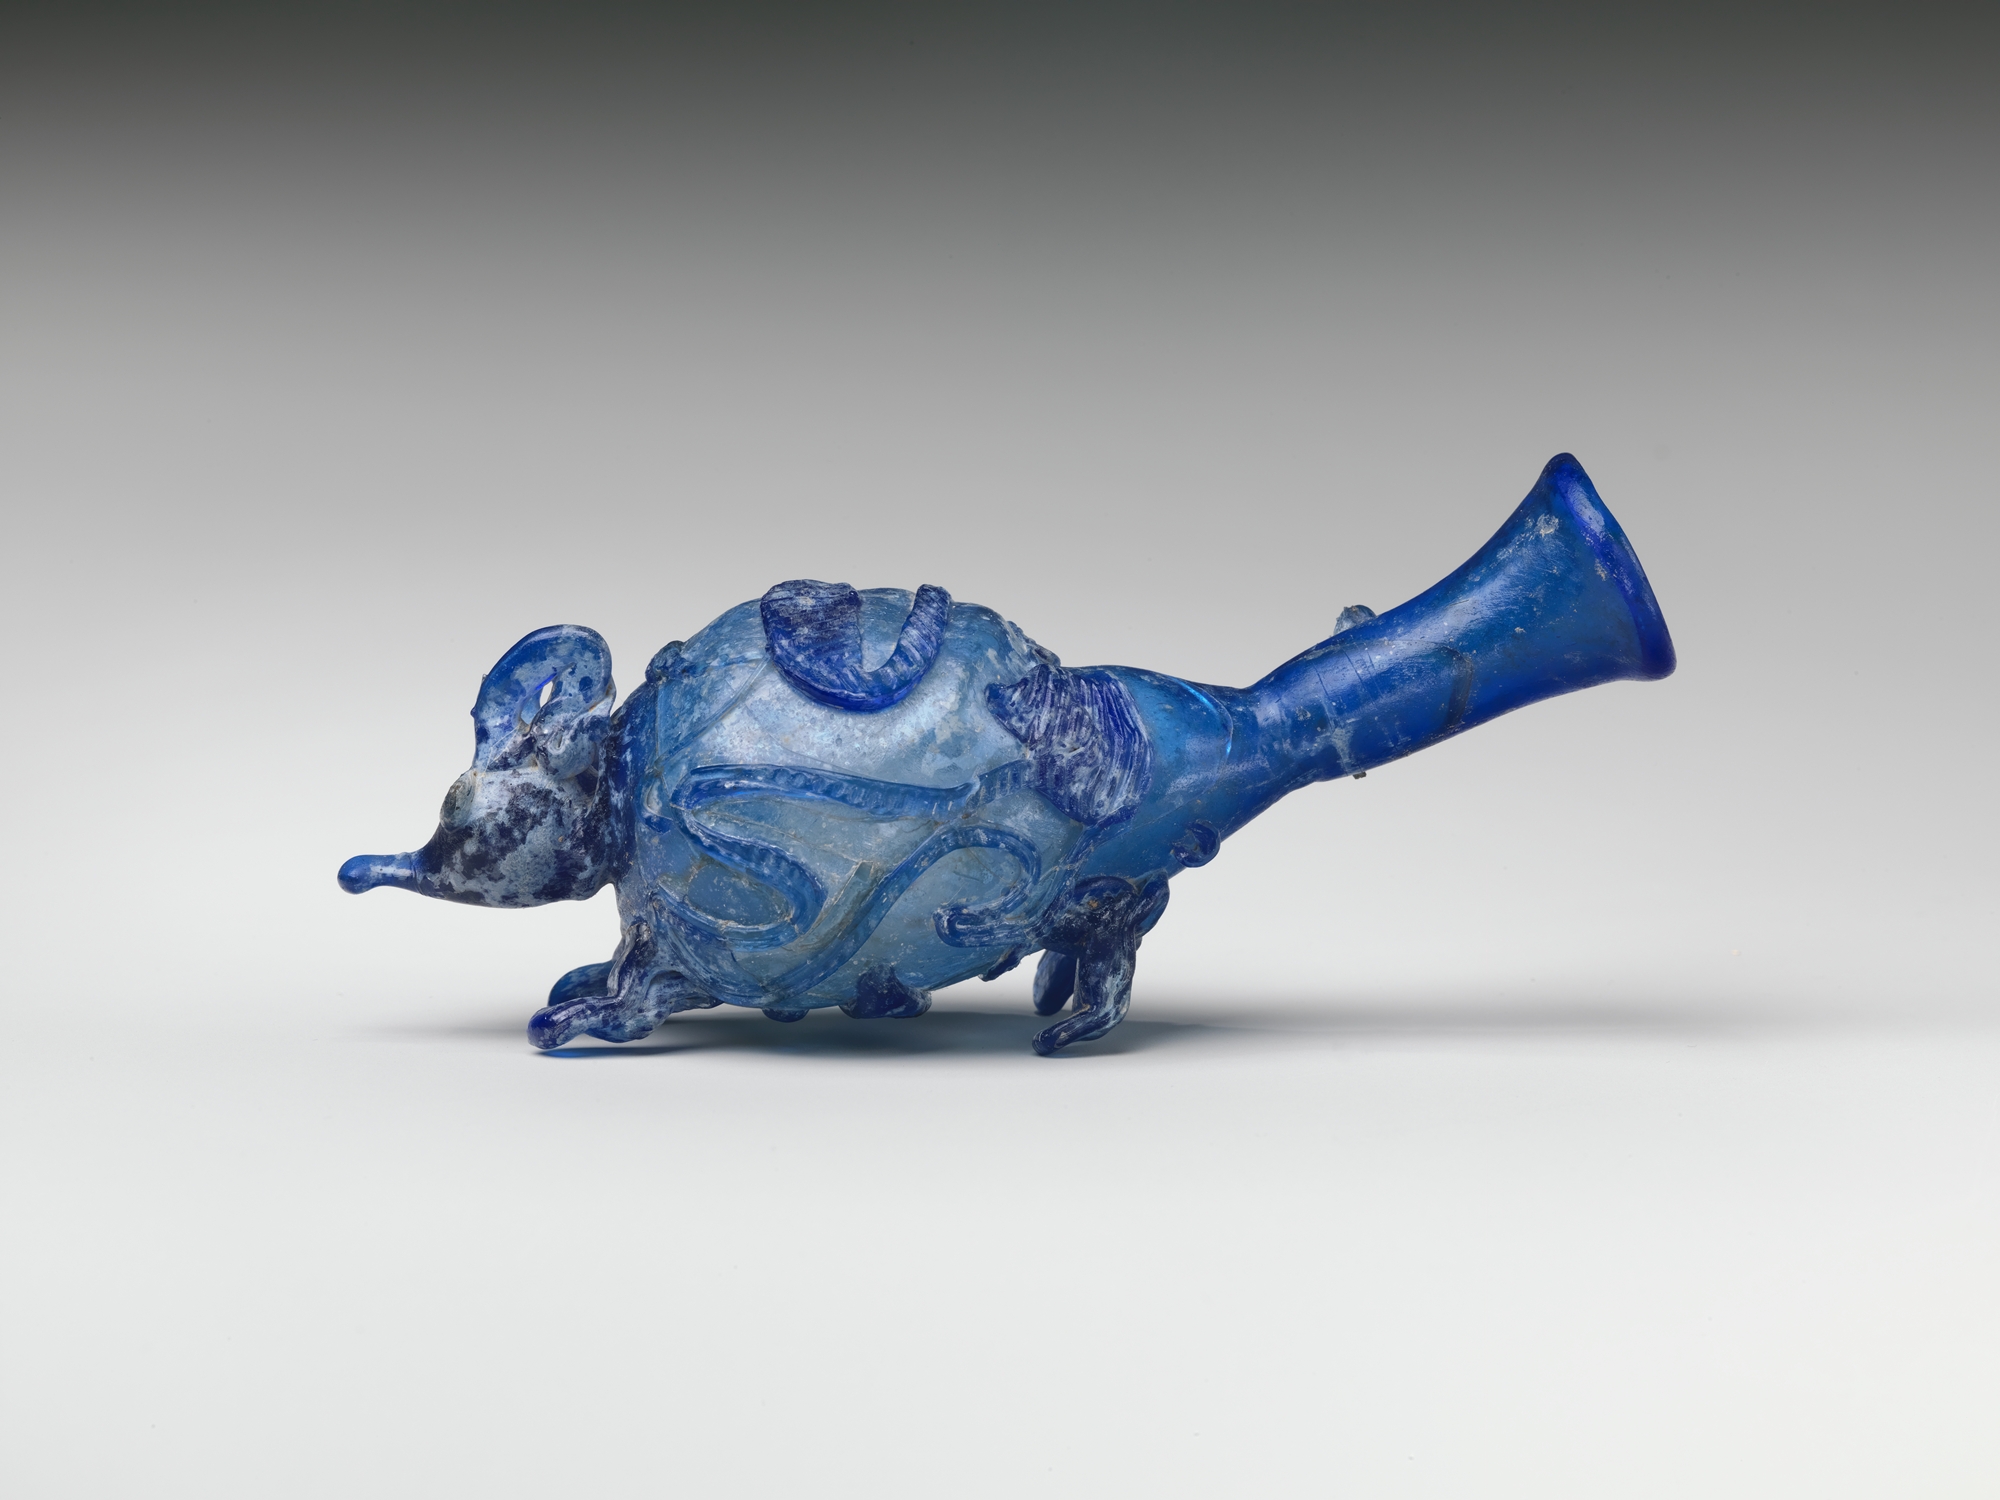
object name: flask, snake thread mouse shaped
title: Glass snake-thread flask shaped like a mouse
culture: roman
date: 201-300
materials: glass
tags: mice